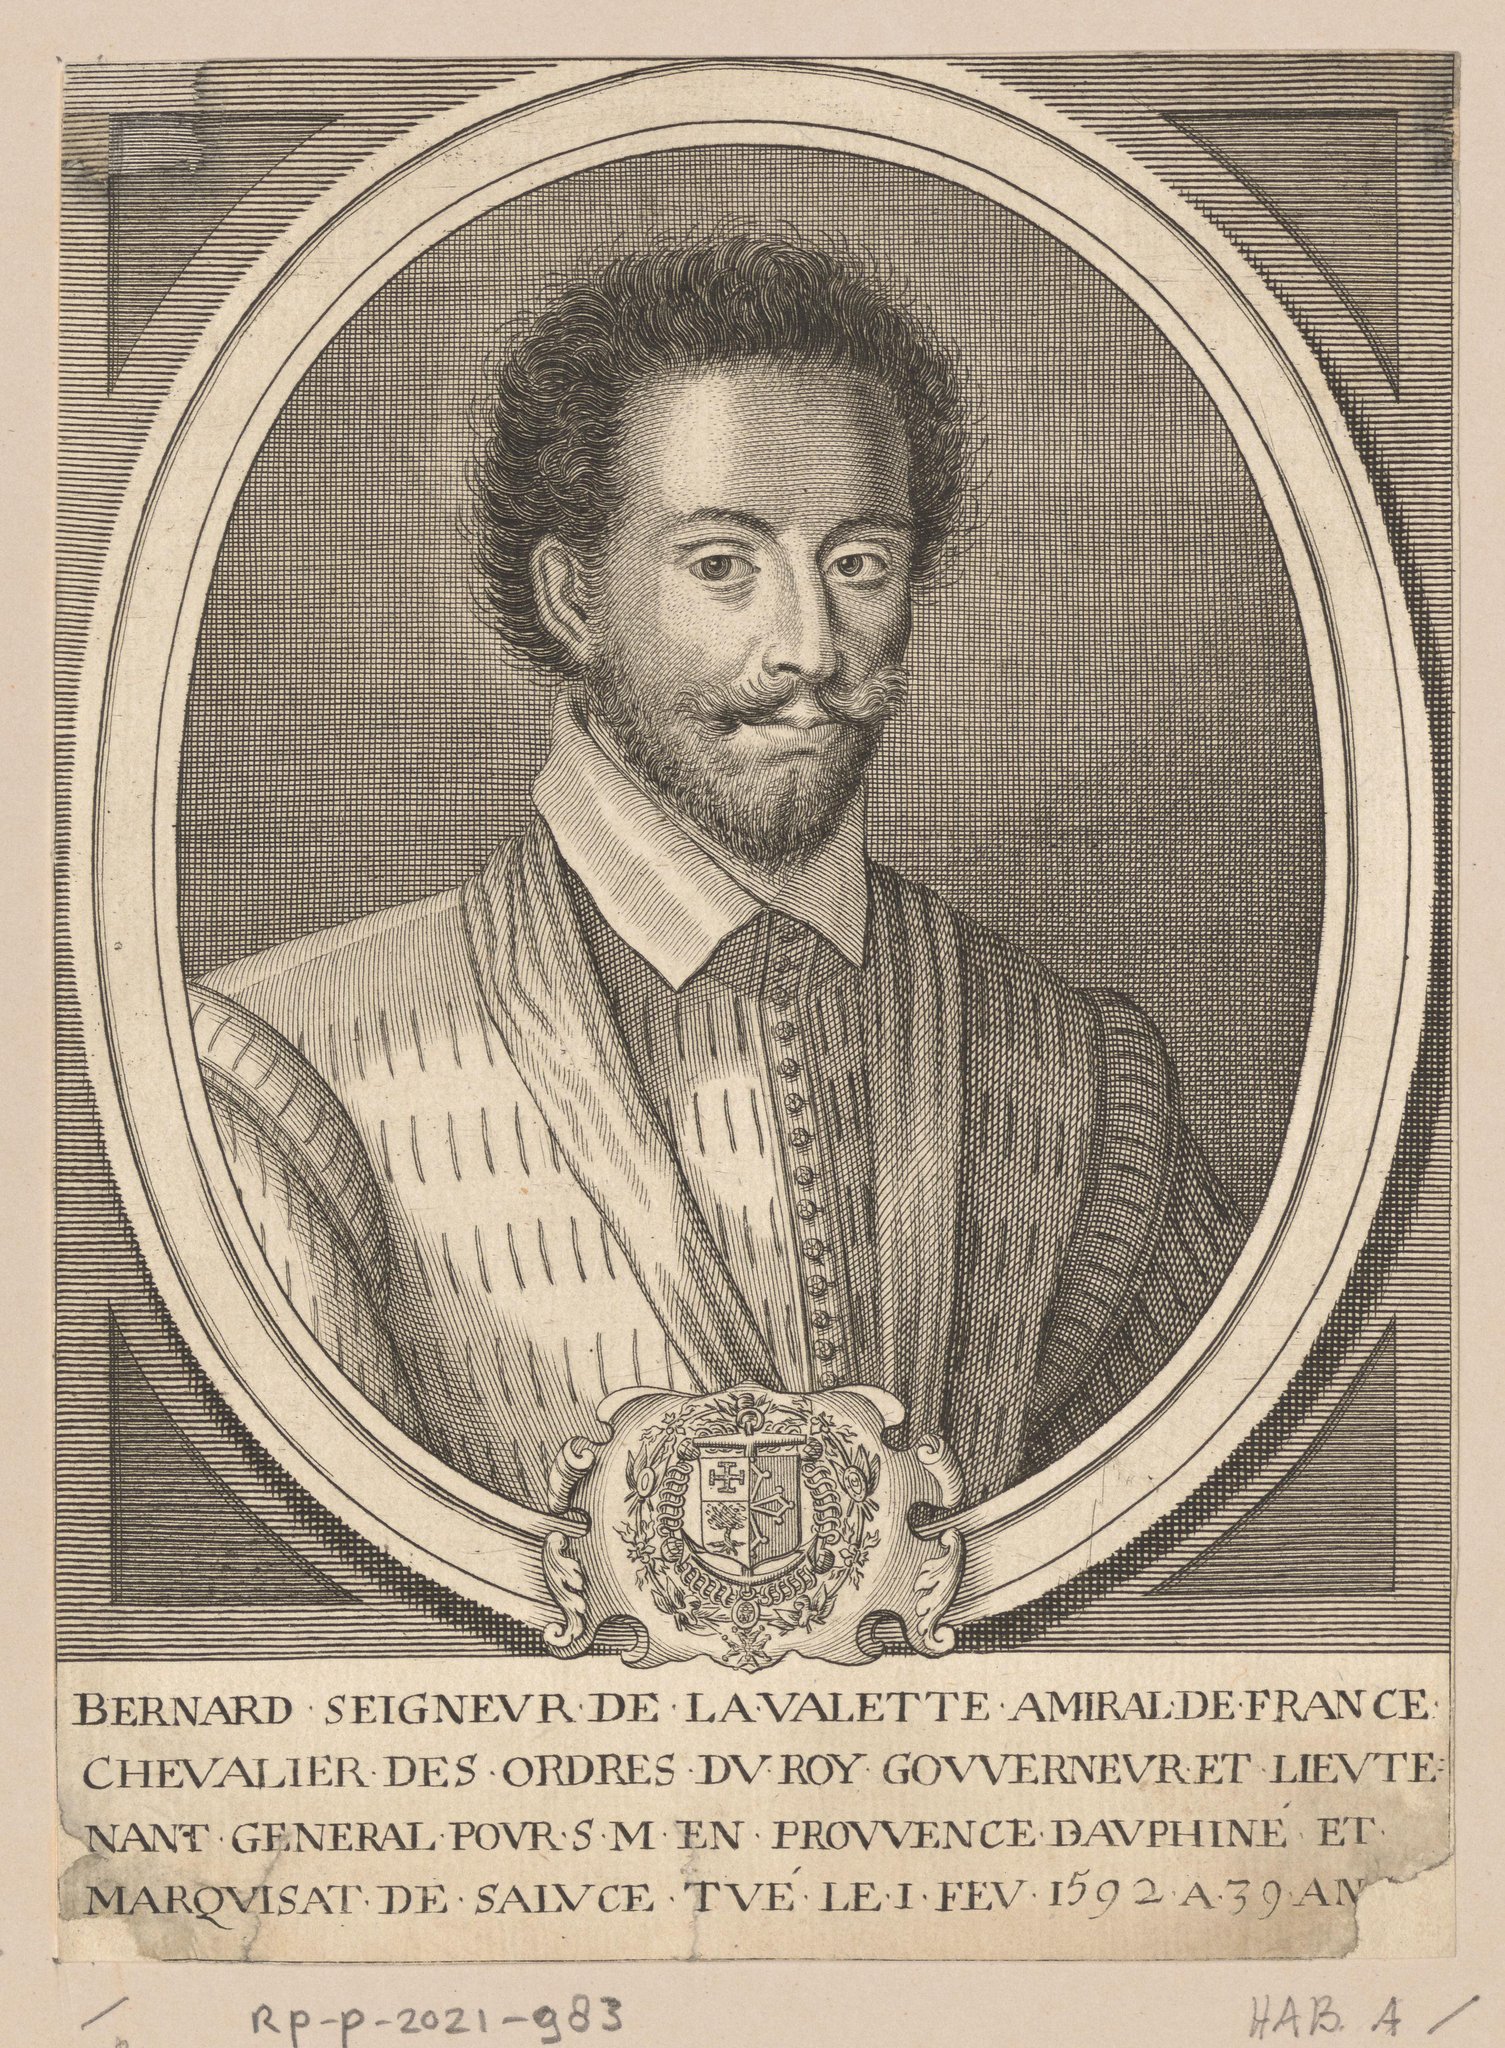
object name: print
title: Portret van Bernard de Nogaret de La Valette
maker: louis boudan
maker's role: print maker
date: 1670-1718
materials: paper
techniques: engraving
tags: historical persons, armorial bearing, heraldry